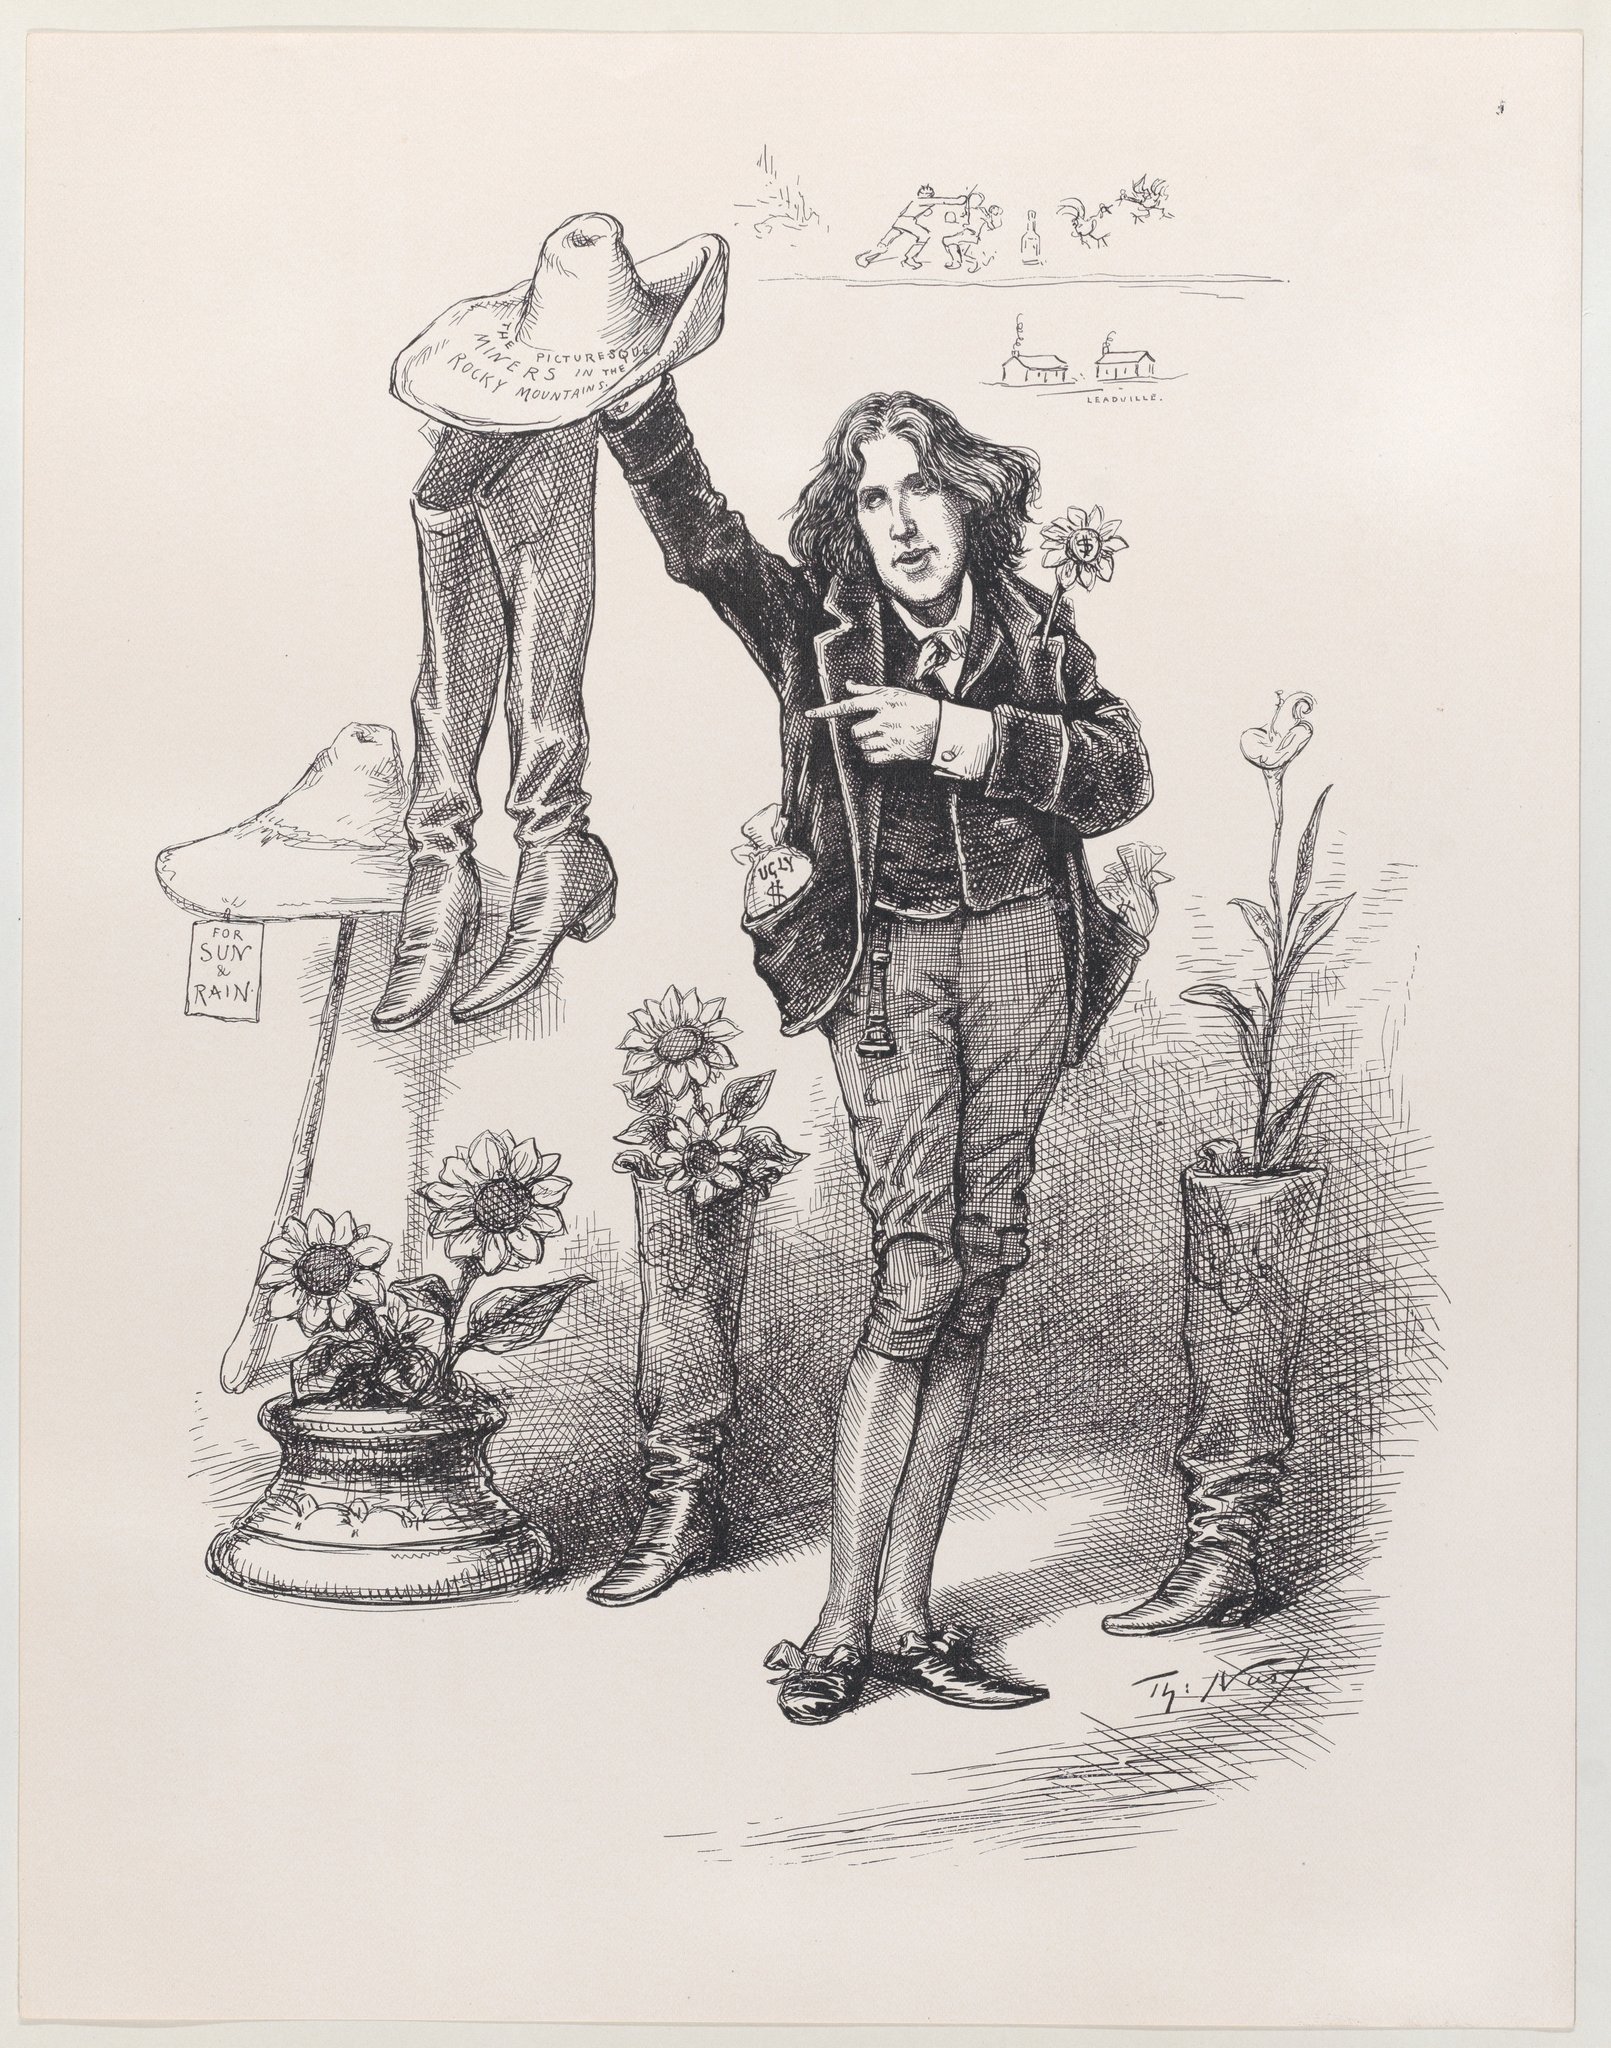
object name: print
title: Wilde on Us. Something To "Live Up" To in America (published in "Harper's Bazar," June 10, 1882)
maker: thomas nast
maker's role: artist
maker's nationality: american, born germany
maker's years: 1840-1902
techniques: relief print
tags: boots,men,caricature